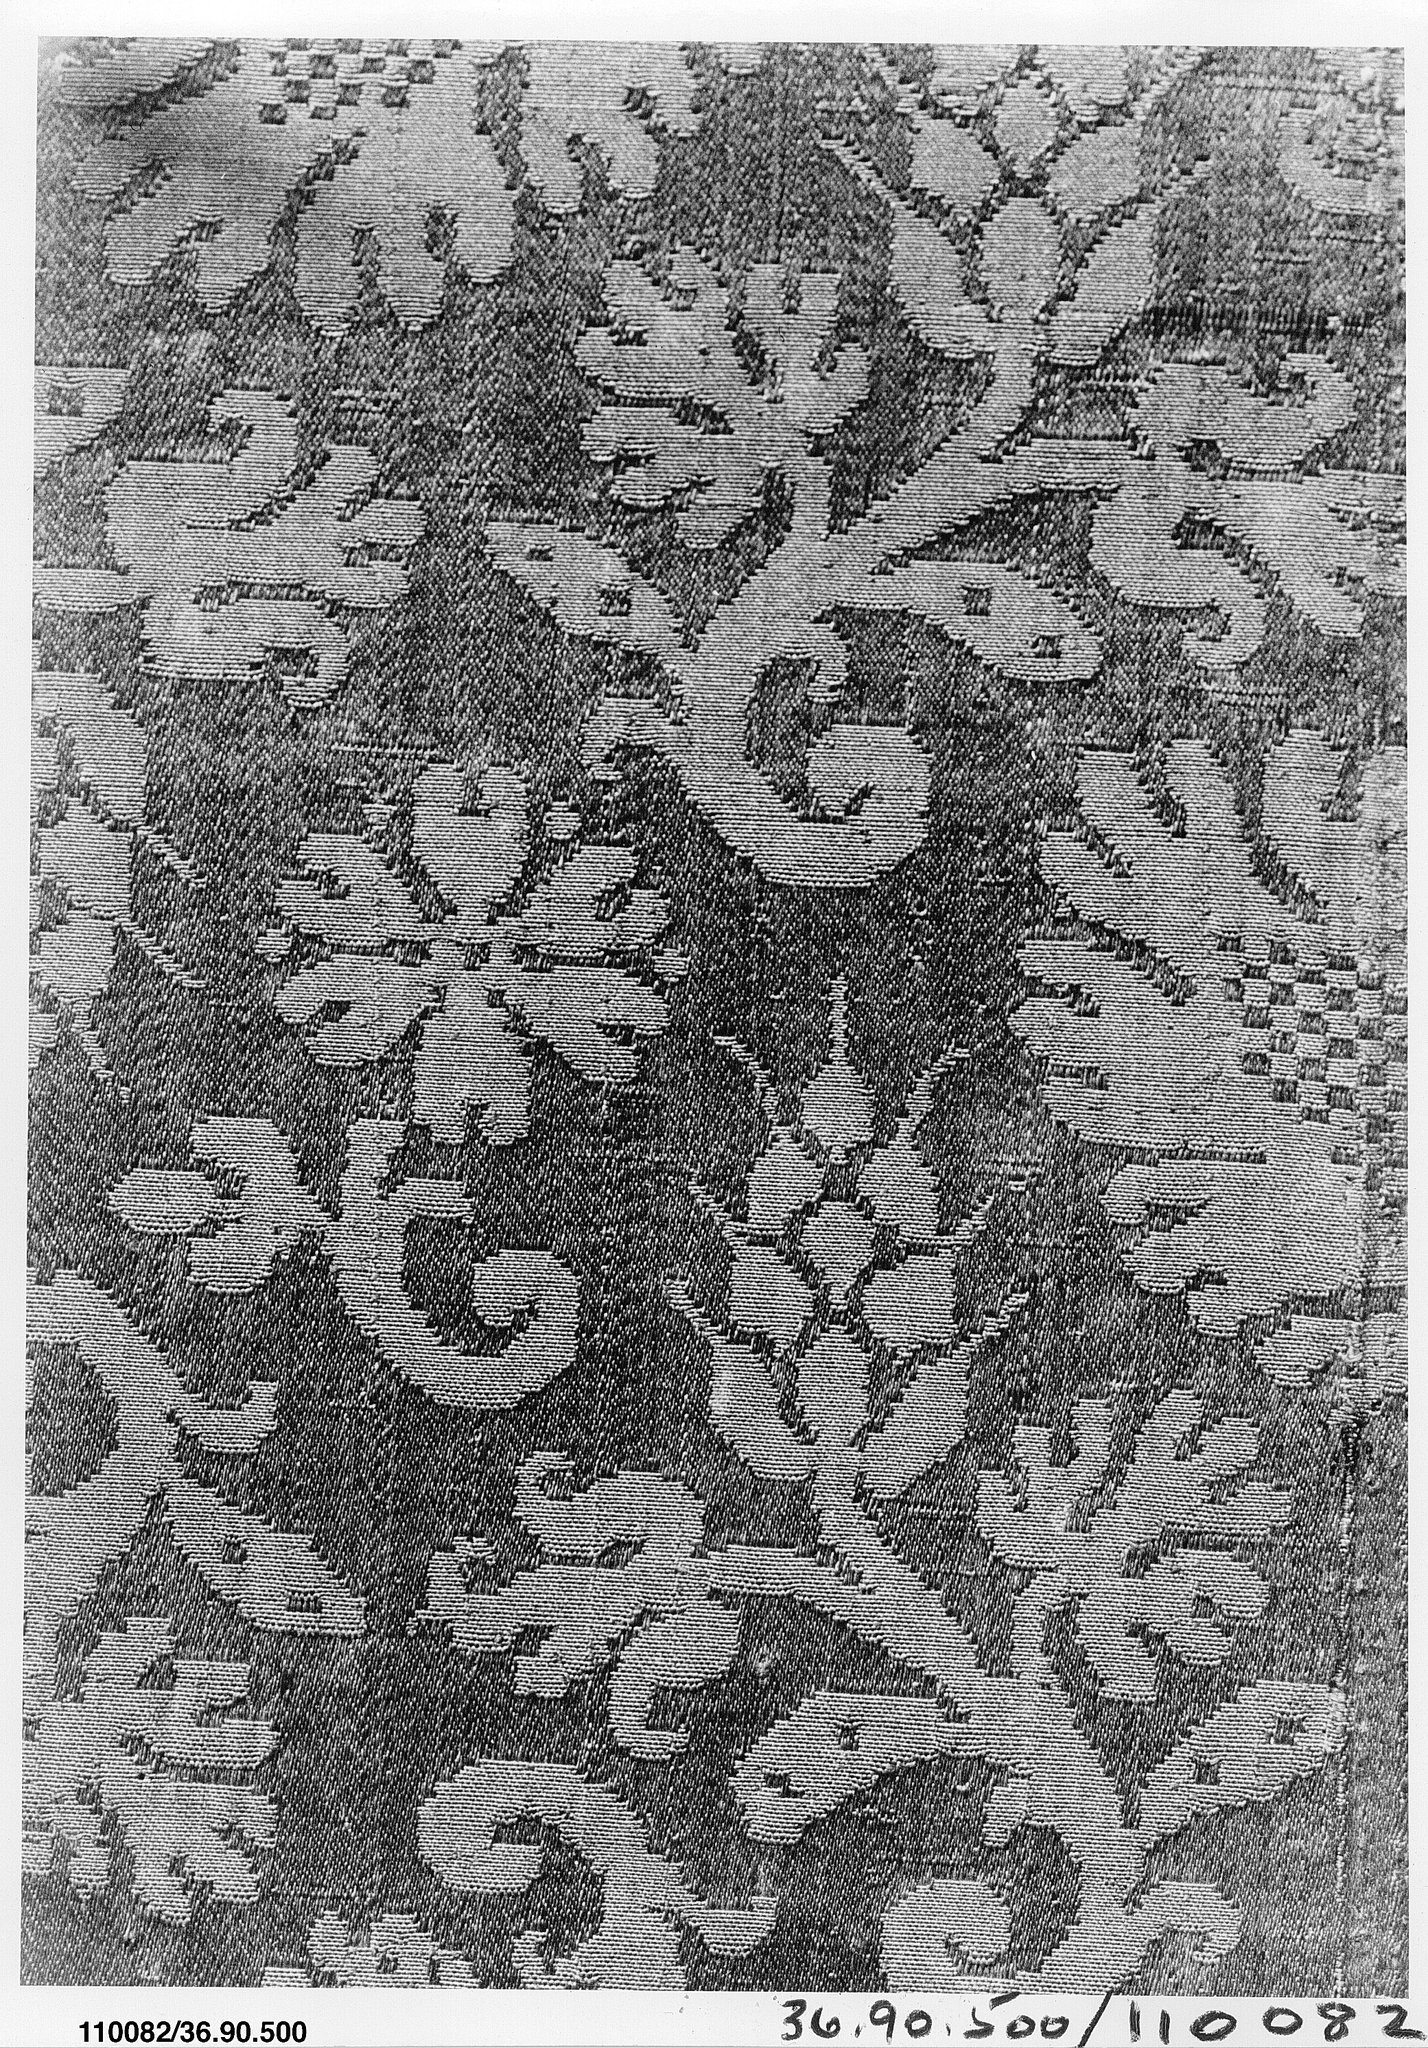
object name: piece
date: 1501-1700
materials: silk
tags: flowers,leaves